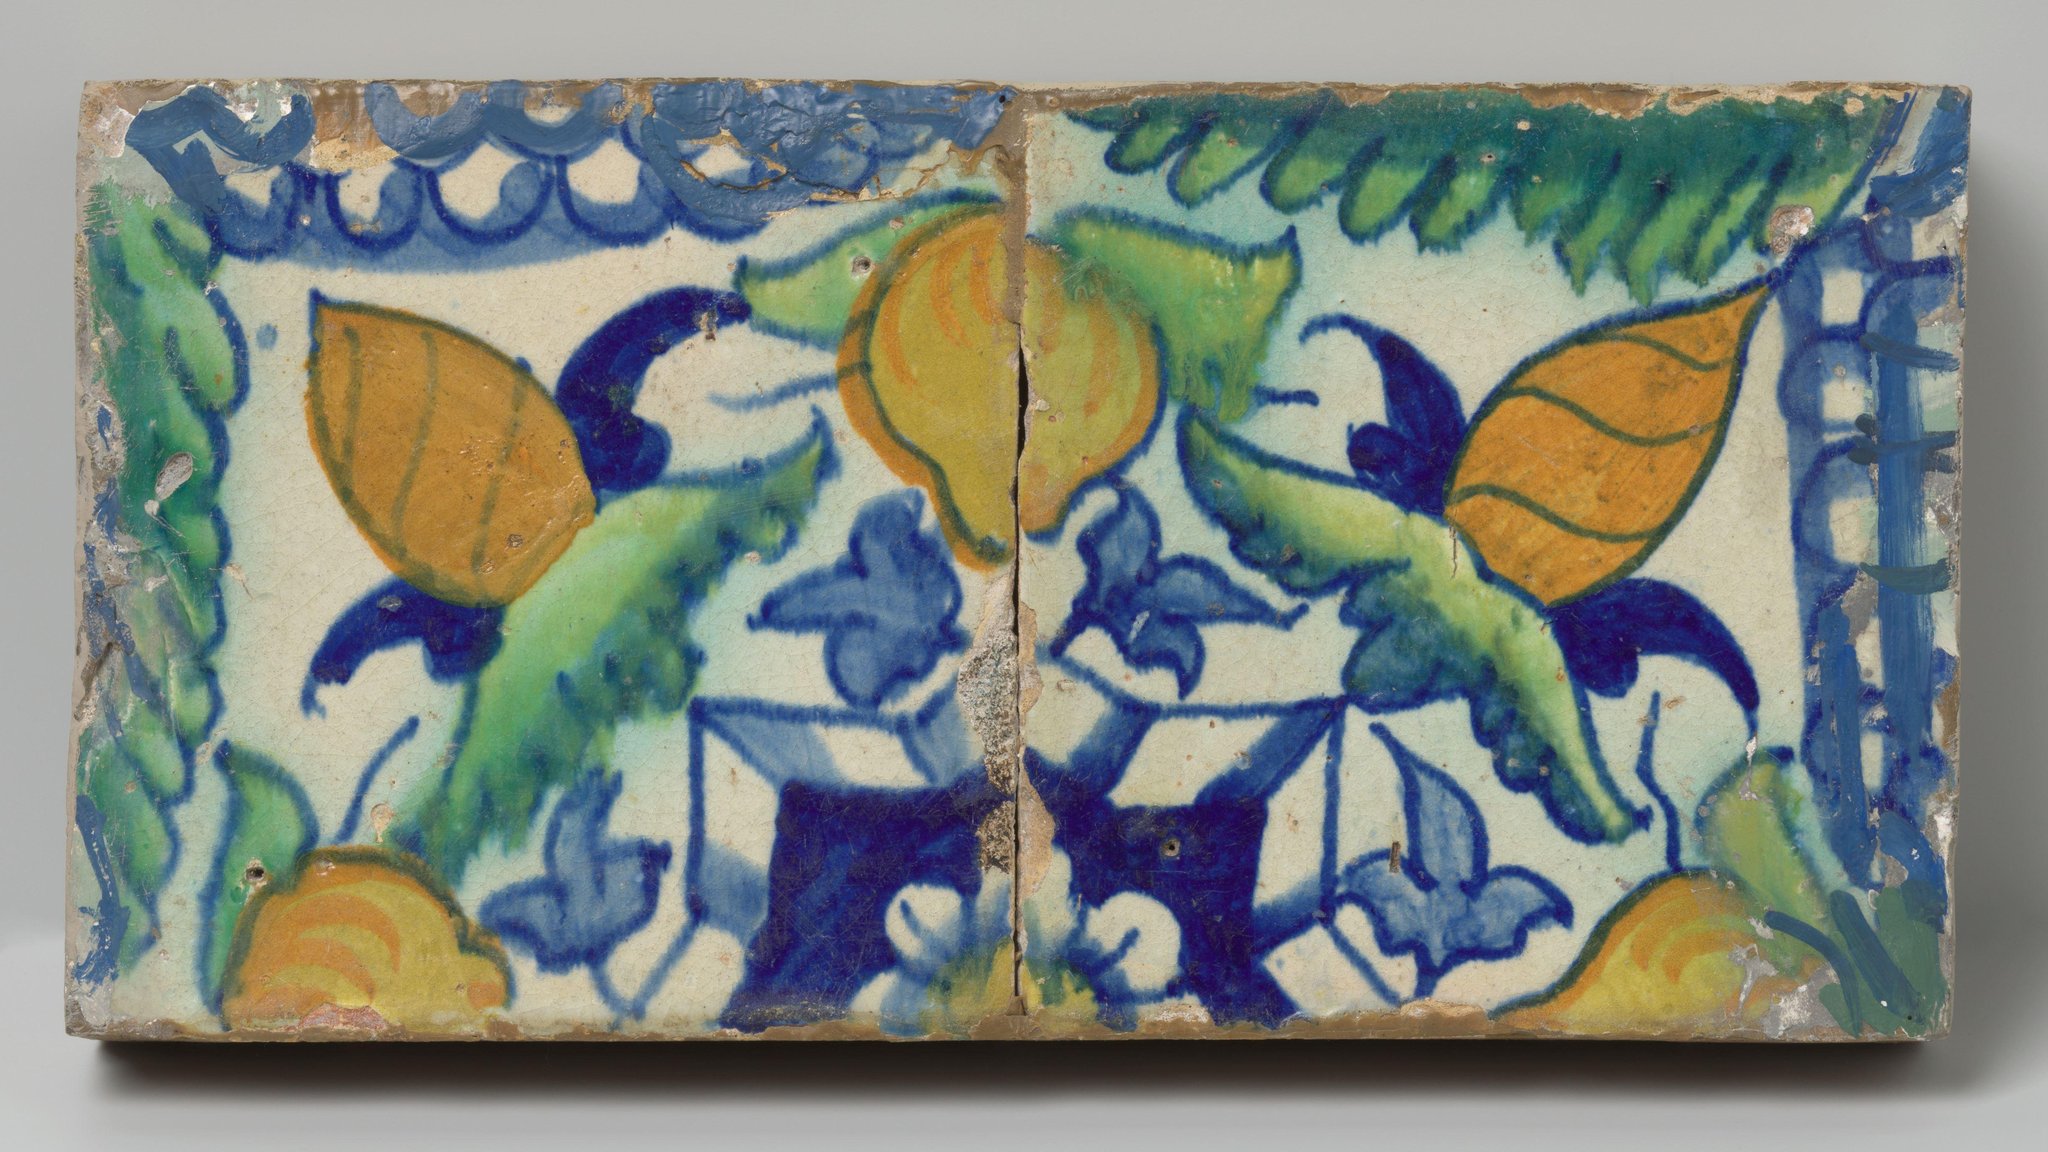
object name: tegelveld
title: Veld van twee tegels met vruchten, bladeren en druiventrossen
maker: Anonymous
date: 1600-1625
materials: earthenware, glaze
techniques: maiolica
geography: netherlands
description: Veld van twee tegels met een veelkleurige (blauw, geel, groen en oranje) voorstelling van vruchten, bladeren en druiventrossen langs de randen. In één van de vier hoeken, een kwart ster.